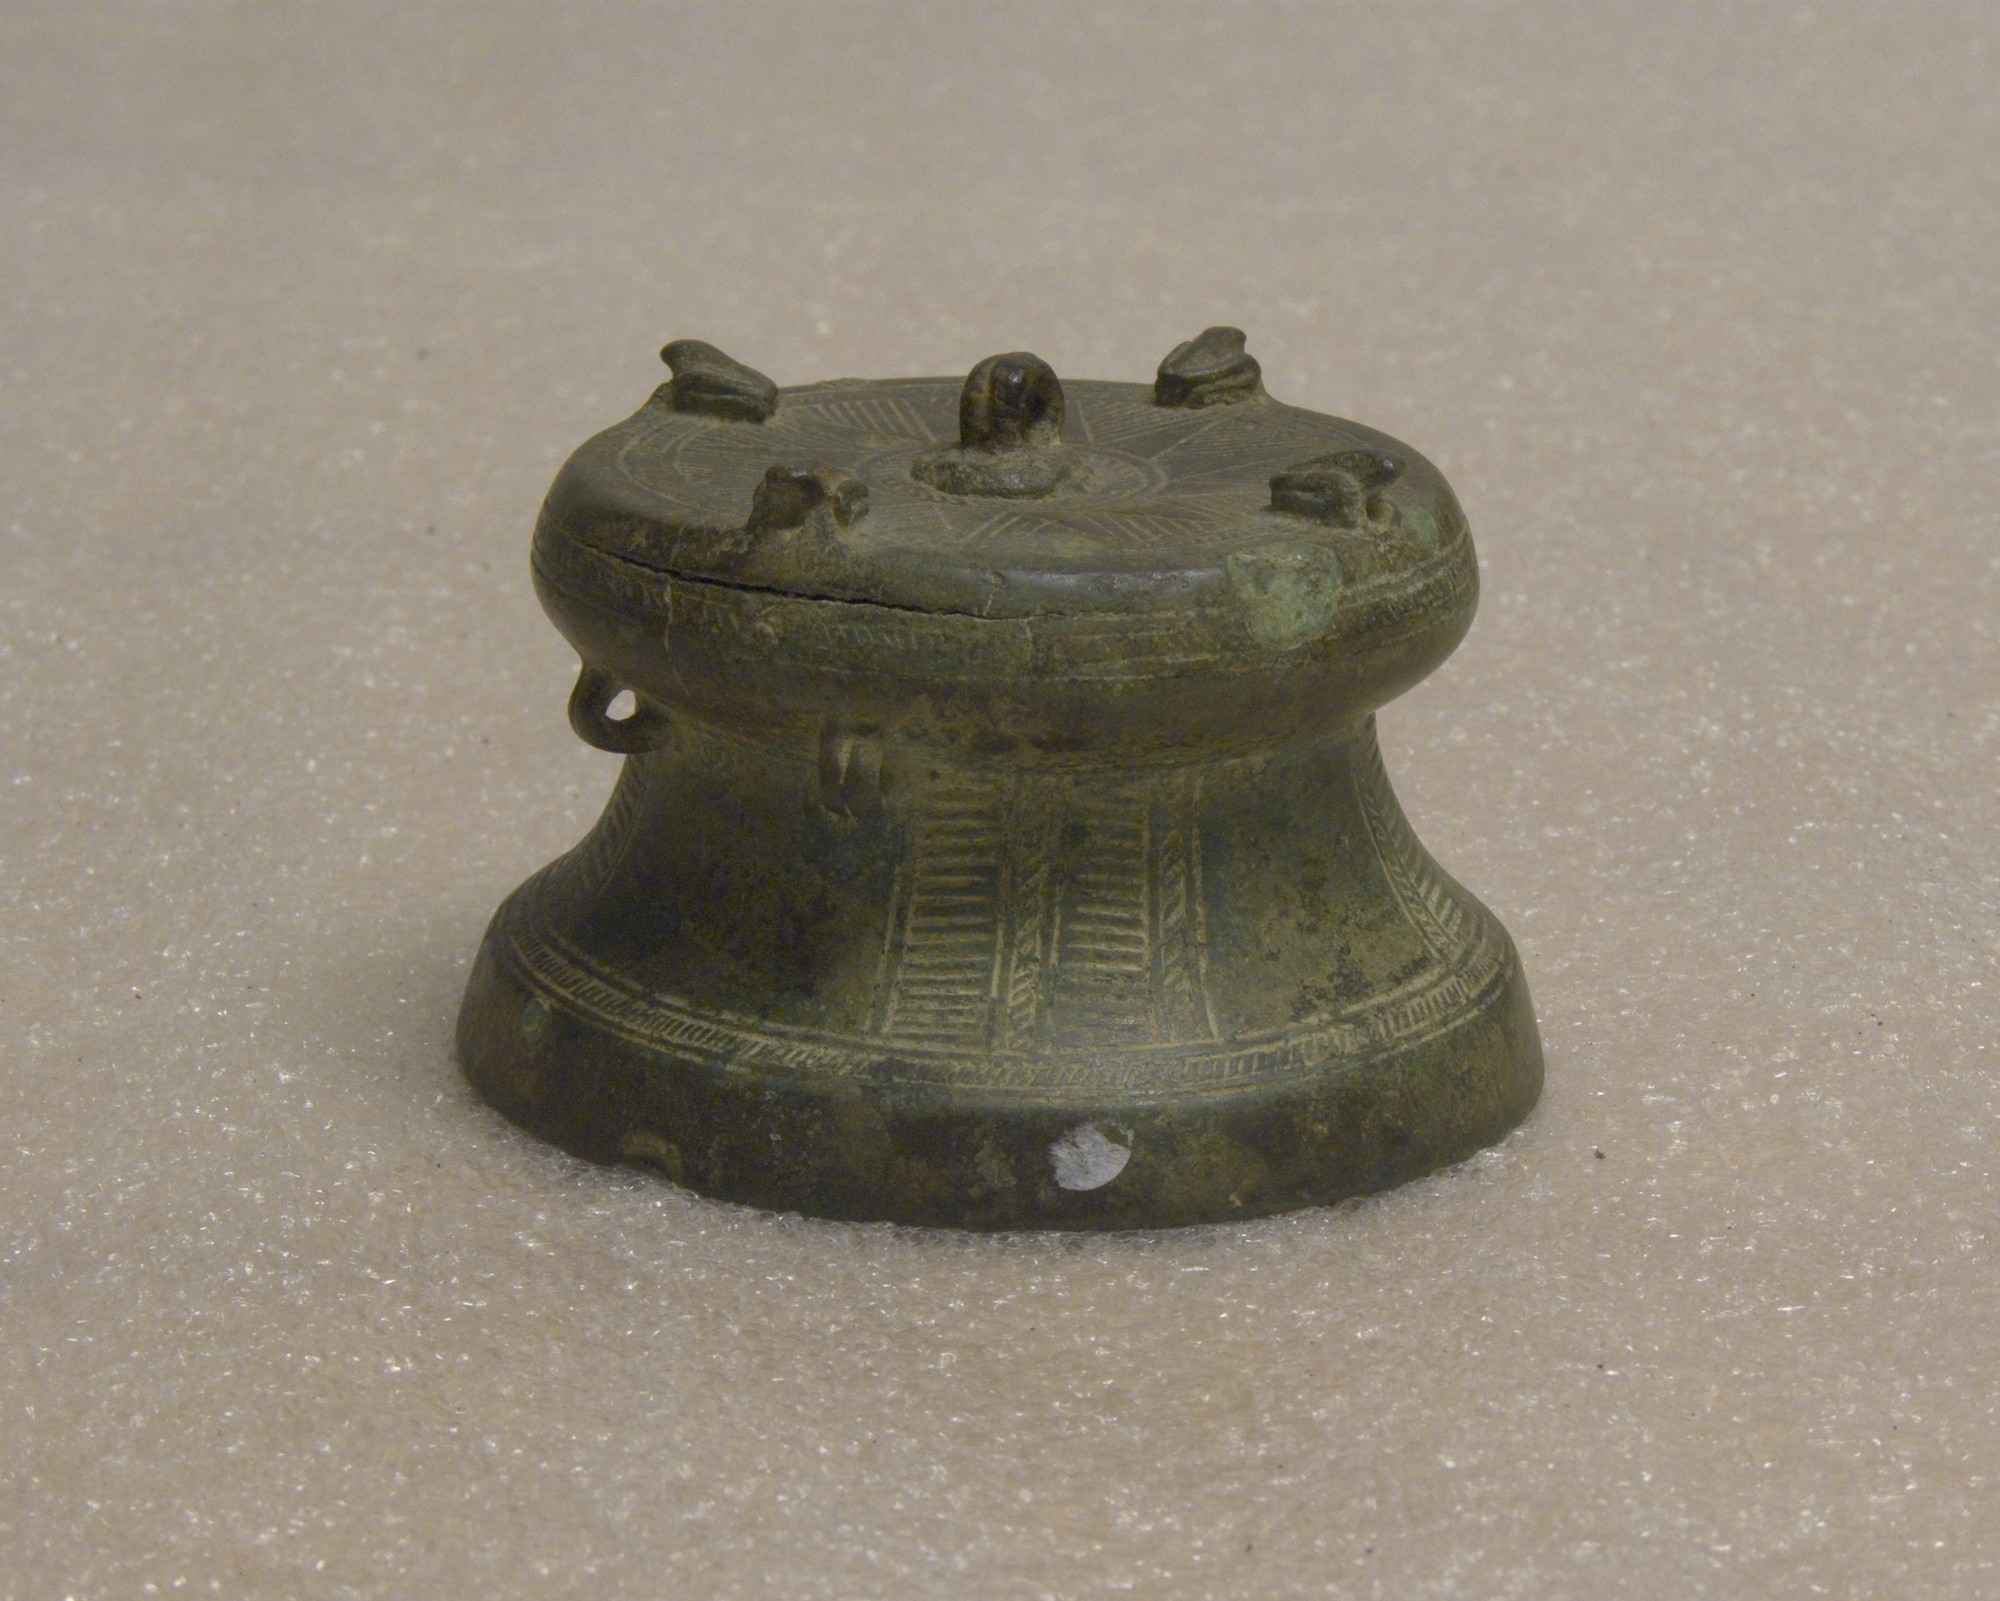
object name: drum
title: Small Drum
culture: vietnamese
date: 500 BCE-300 CE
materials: bronze